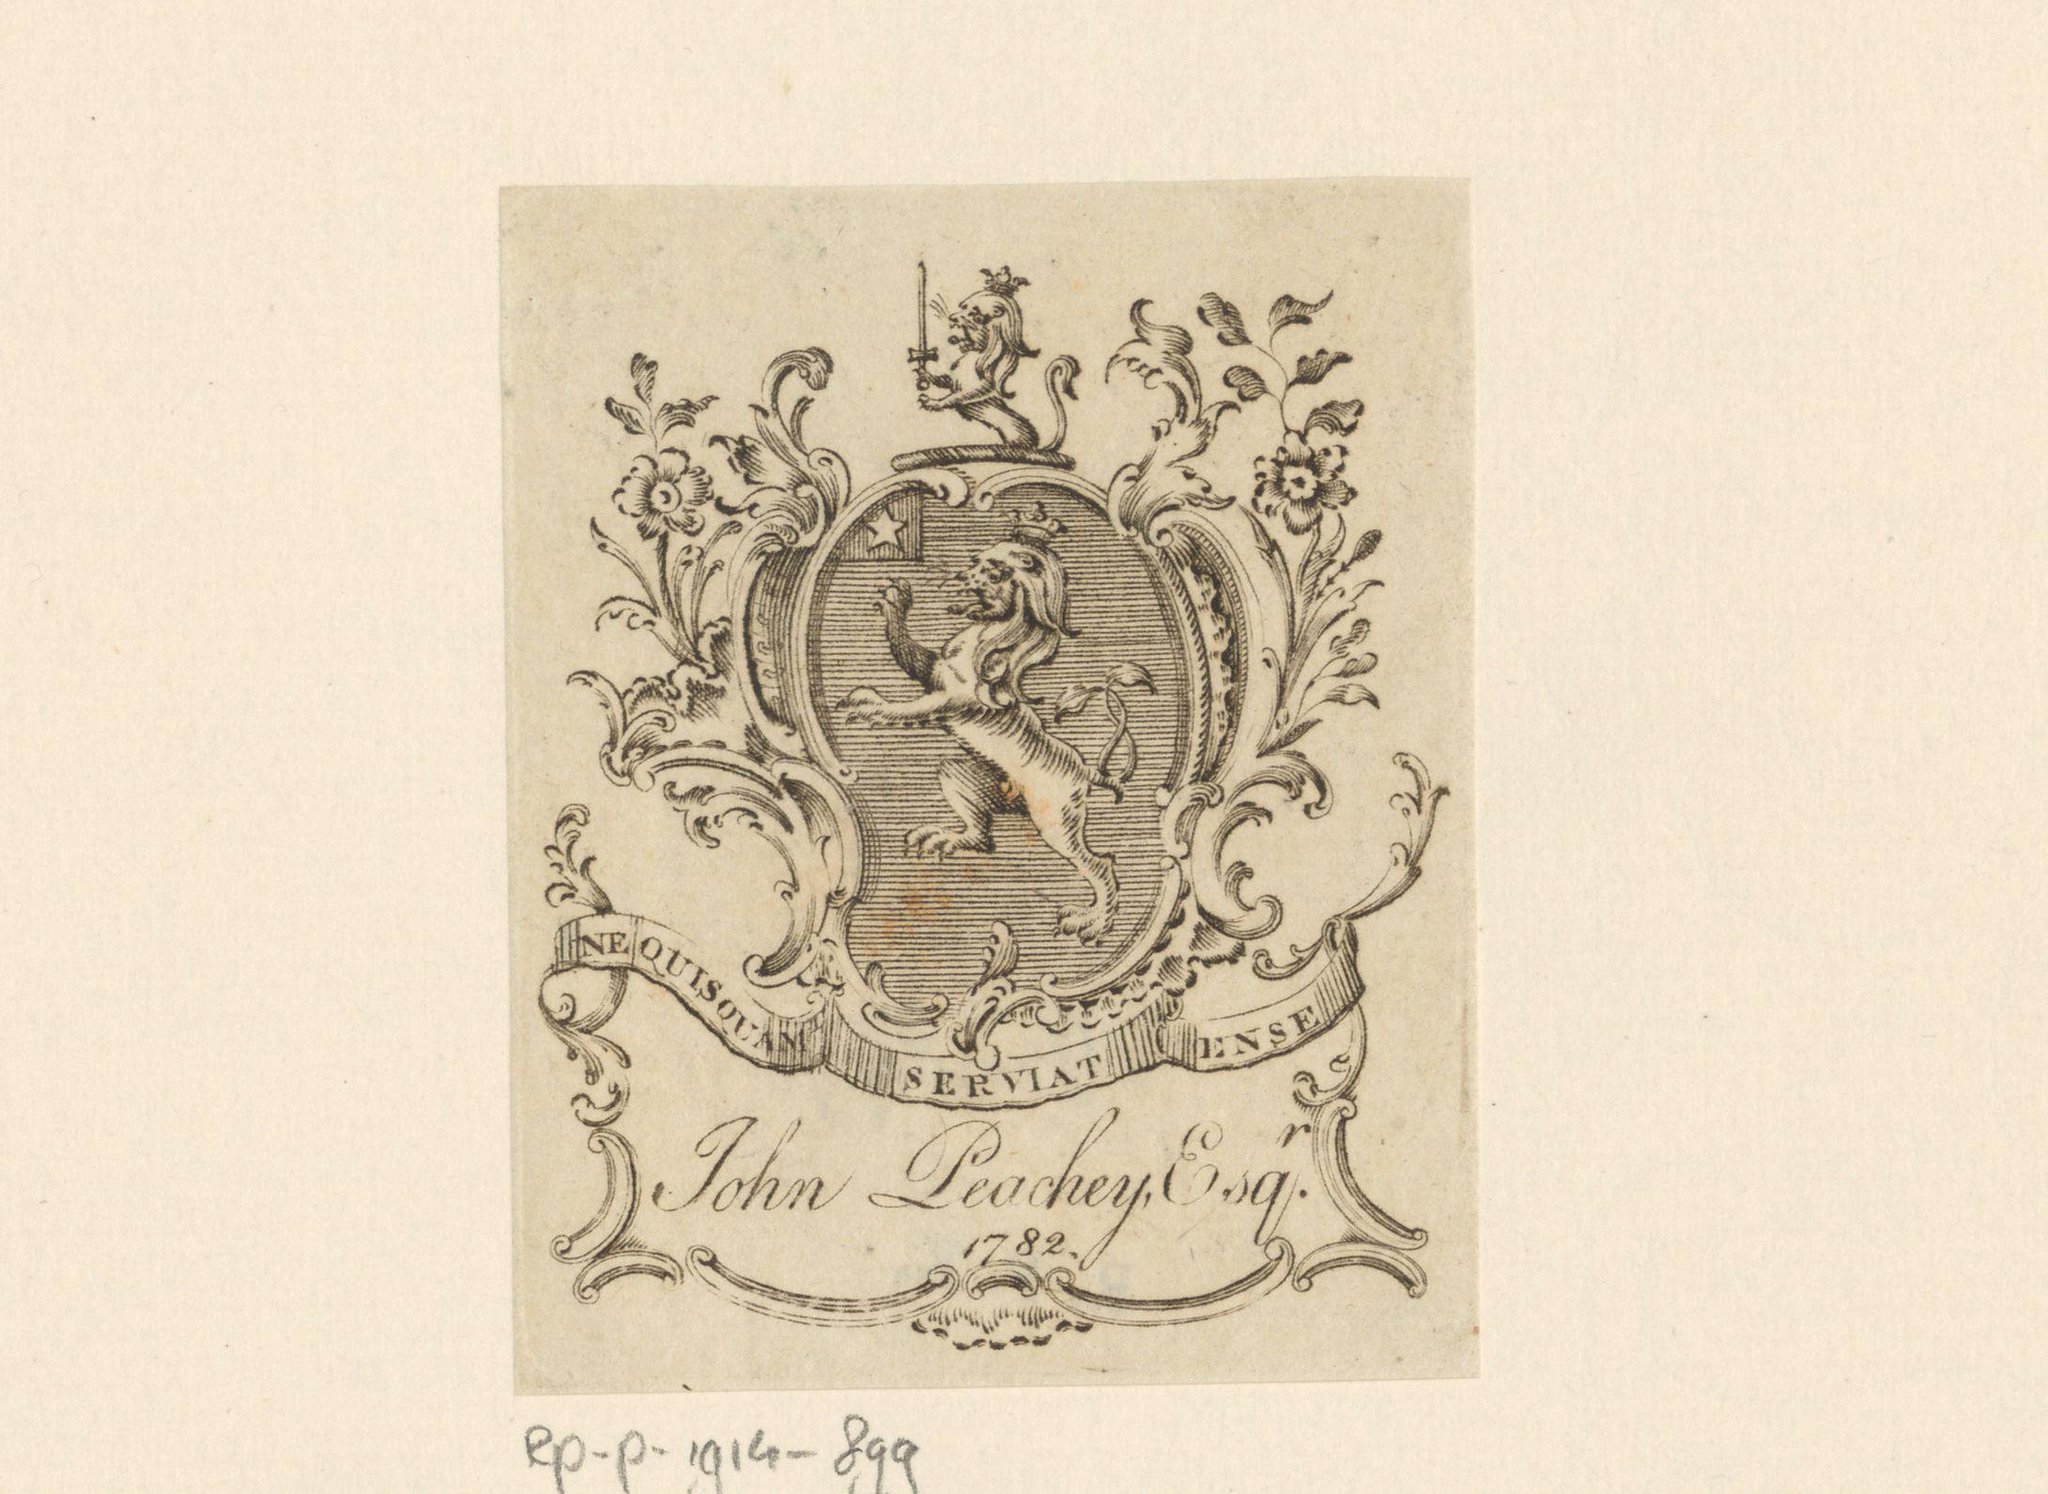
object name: bookplate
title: Ex libris van John Peachey Esqr.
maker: Anonymous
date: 1782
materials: paper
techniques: engraving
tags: armorial bearing, heraldry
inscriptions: collector's mark: Lugt 2760, collector's mark: Lugt 2233